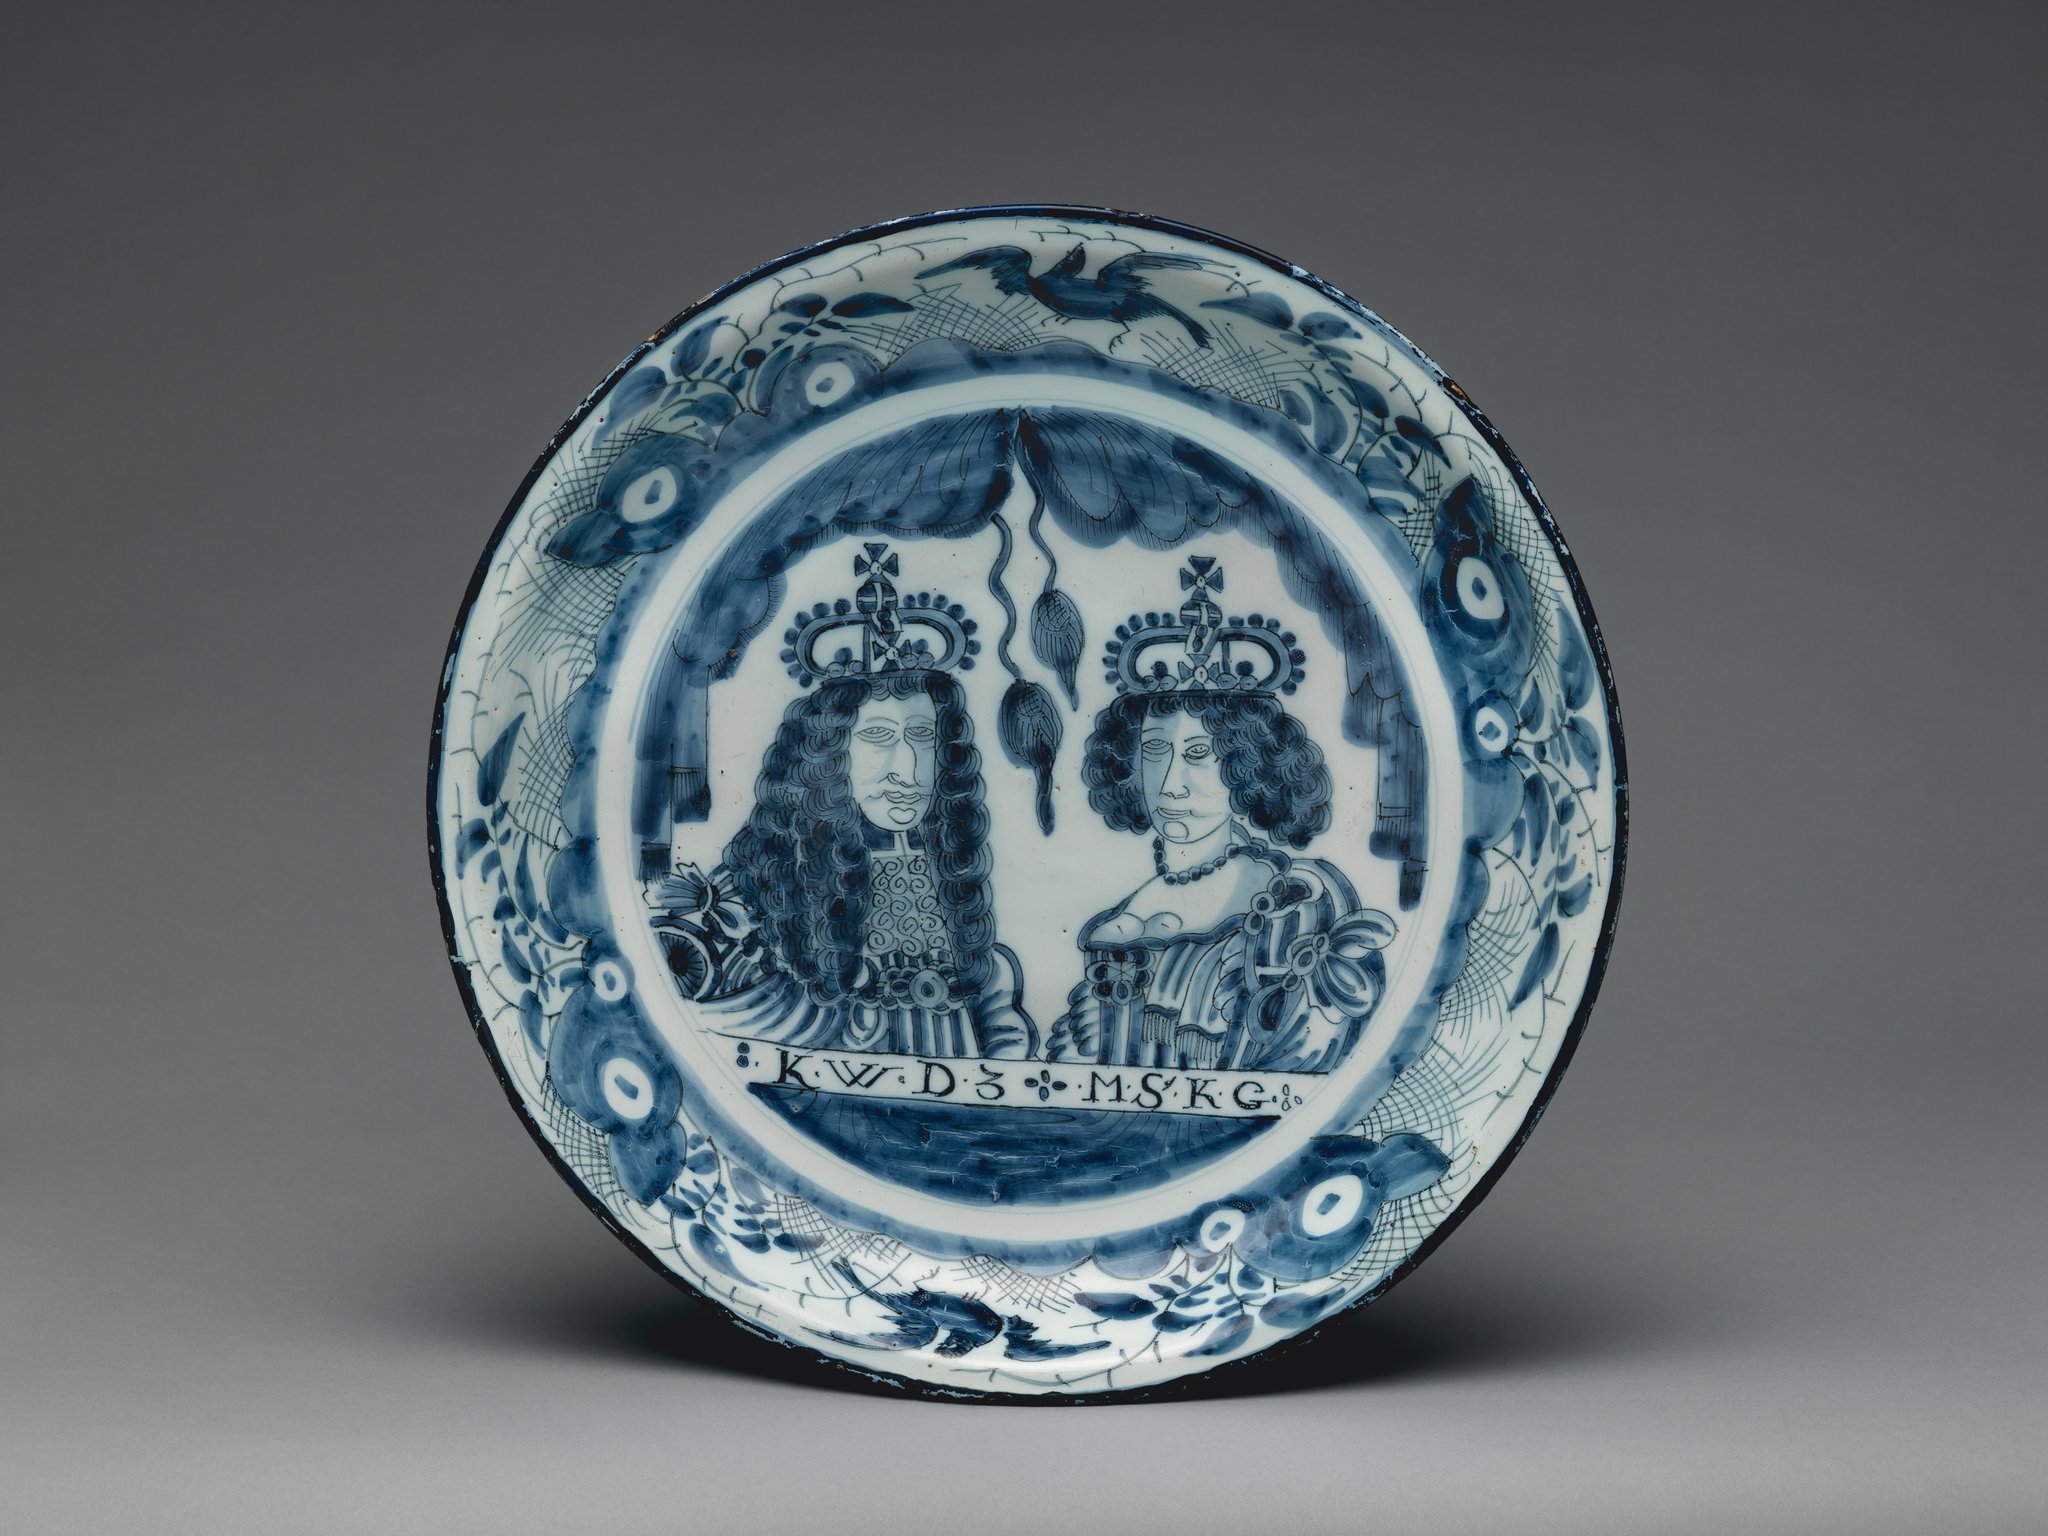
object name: charger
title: Charger with double portrait of William III and Mary II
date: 1690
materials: earthenware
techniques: glazing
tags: kings,queens